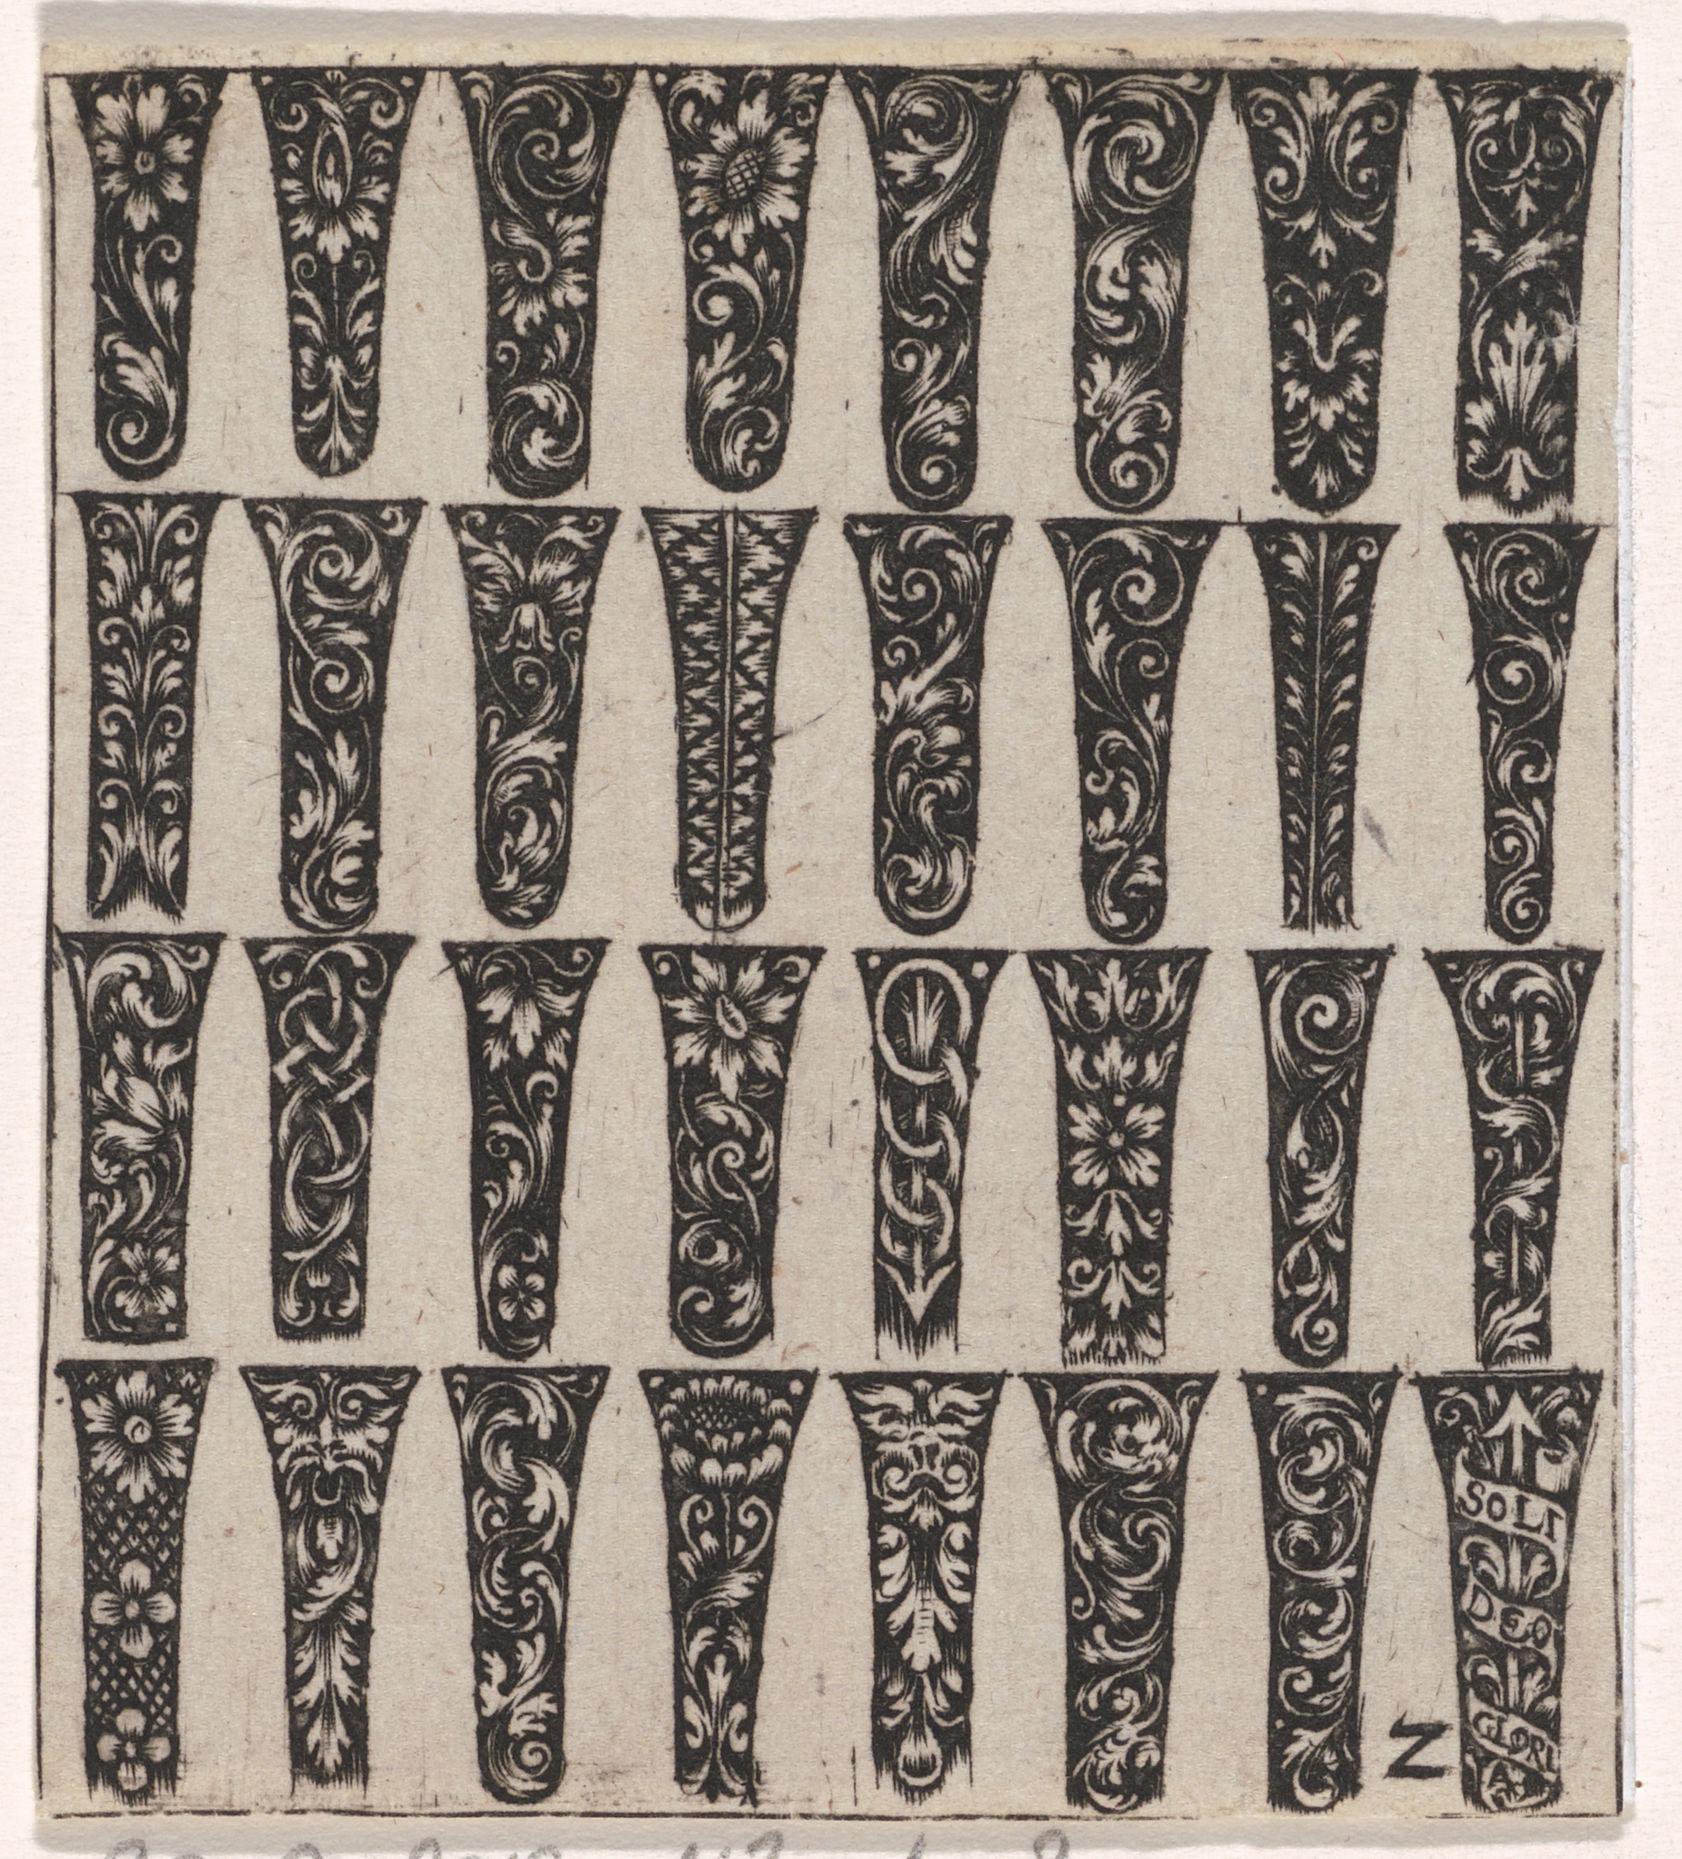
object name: ornament print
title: Voorbeelden van 32 kleine objecten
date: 1647-1709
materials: paper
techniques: engraving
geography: nuremberg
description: Voorbeelden van 32 kleine objecten, mogelijk ringen.